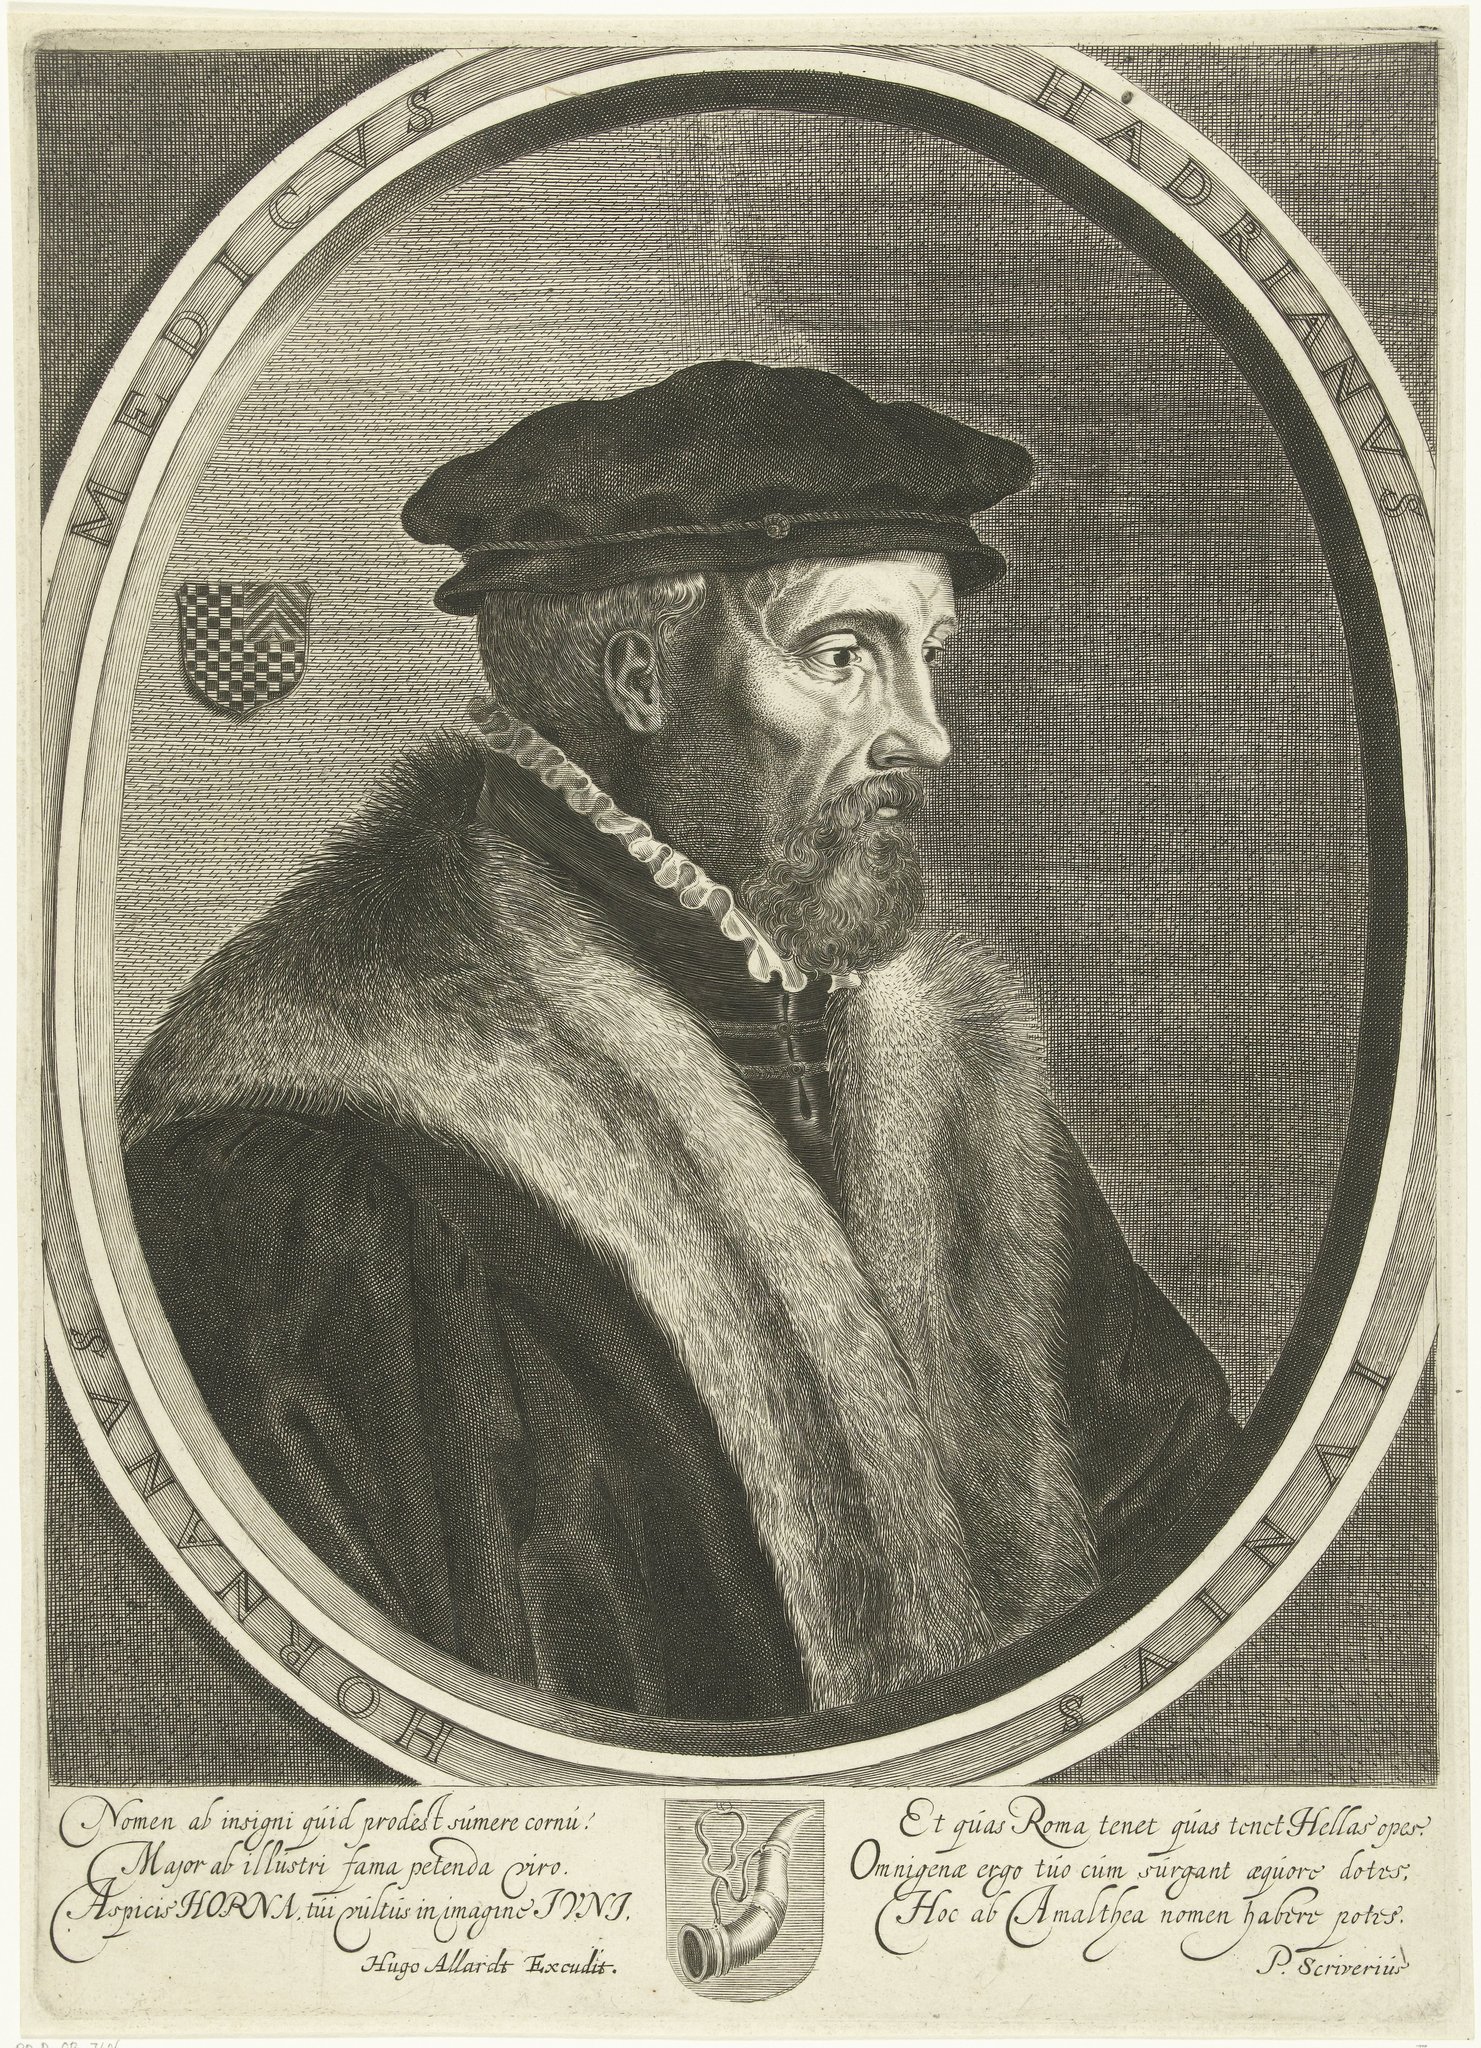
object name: print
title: Portret van Hadrianus Junius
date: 1640-1671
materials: paper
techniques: engraving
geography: amsterdam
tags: hoorn (north holland), middelburg, hadrianus junius, historical persons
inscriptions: collector's mark: Lugt 2228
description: Borstbeeld van Hadrianus Junius, arts in Hoorn. In ovale omlijsting met randschrift. Onder het portret een Latijns vers en het stadswapen van Hoorn.